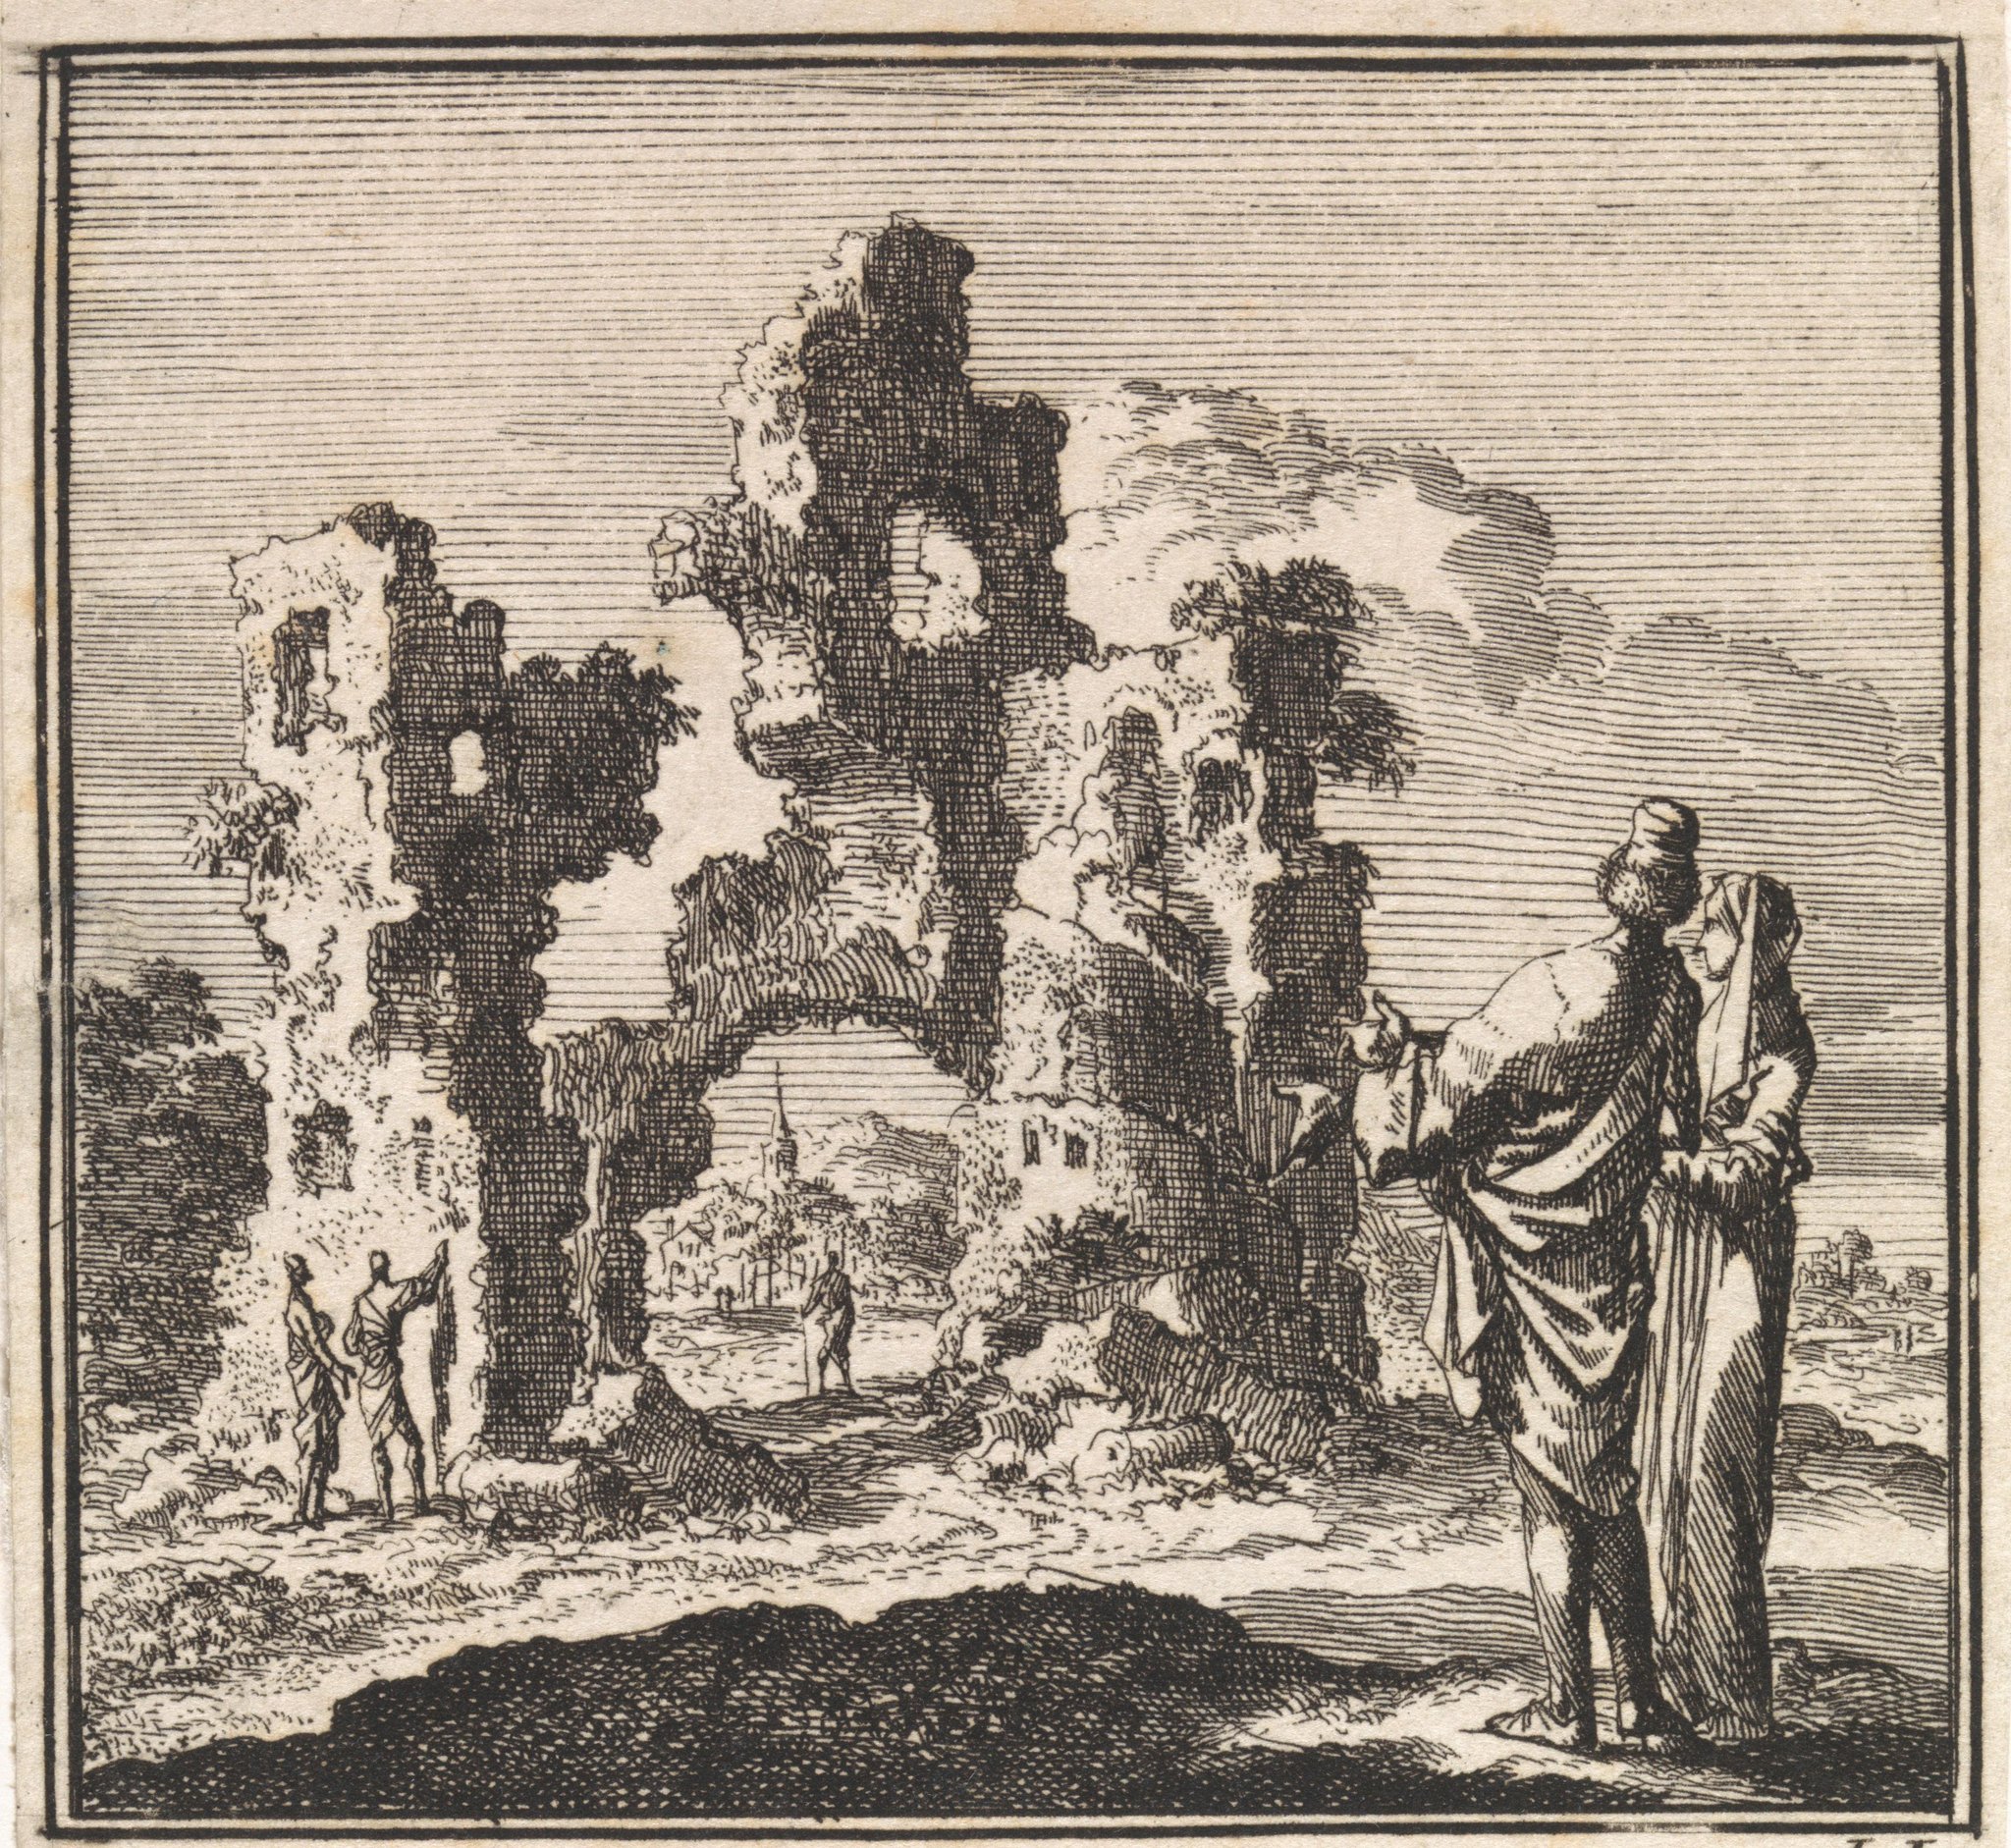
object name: book illustration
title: Twee figuren kijken naar de ruïne van een kasteel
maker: jan luyken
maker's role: draughtsman, print maker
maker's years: 1649-1712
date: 1711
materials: paper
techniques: etching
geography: amsterdam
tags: ruin of a dwelling, house, castle, etc.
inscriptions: collector's mark: Lugt 2228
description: Illustratie voor: Luyken, Jan. De Bykorf des Gemoeds. Amsterdam: Pieter Arentsz. II (wed.) en Cornelis van der Sys, 1711, p. 6.